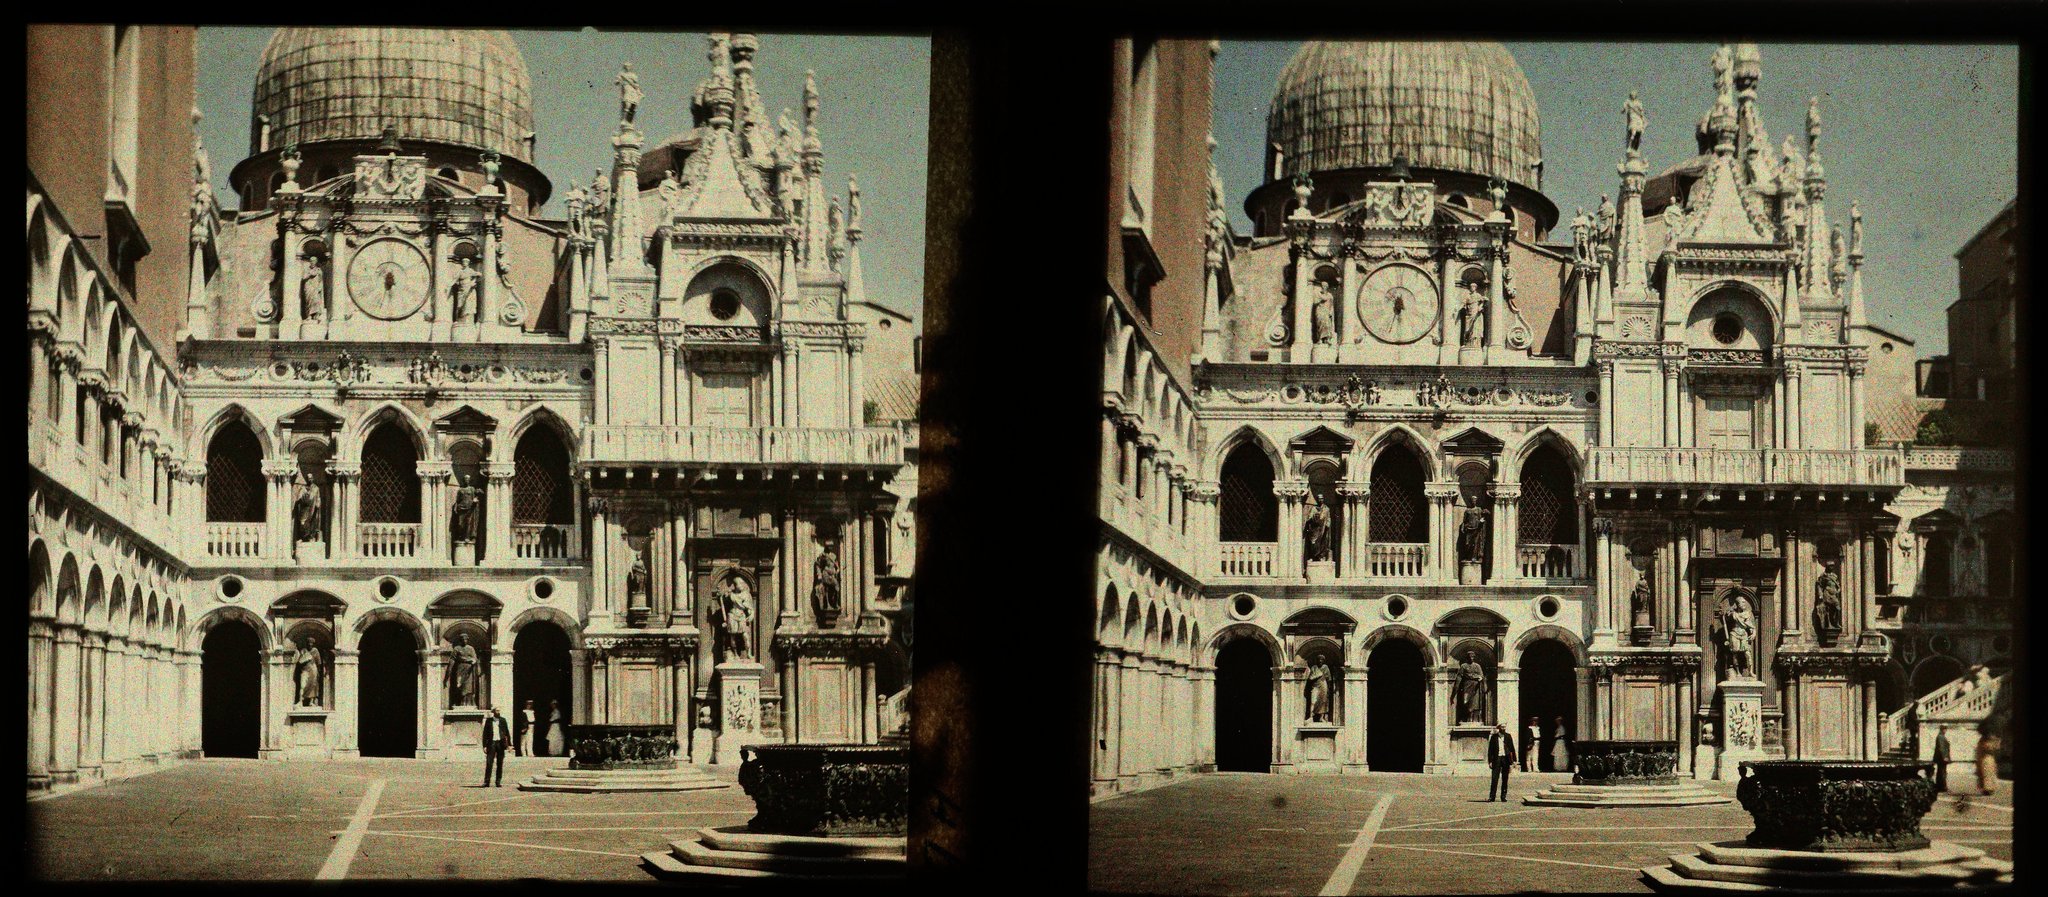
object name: color slide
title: Het Dogenpaleis (Palazzo Ducale) in Venetië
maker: Anonymous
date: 1907-1930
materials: glass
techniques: autochrome process, slide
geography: italy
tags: dogepaleis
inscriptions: annotation: ‘9H / f [?] 8 / 11" / Venise / Intr palais / des Doges / [in potlood:] 204’